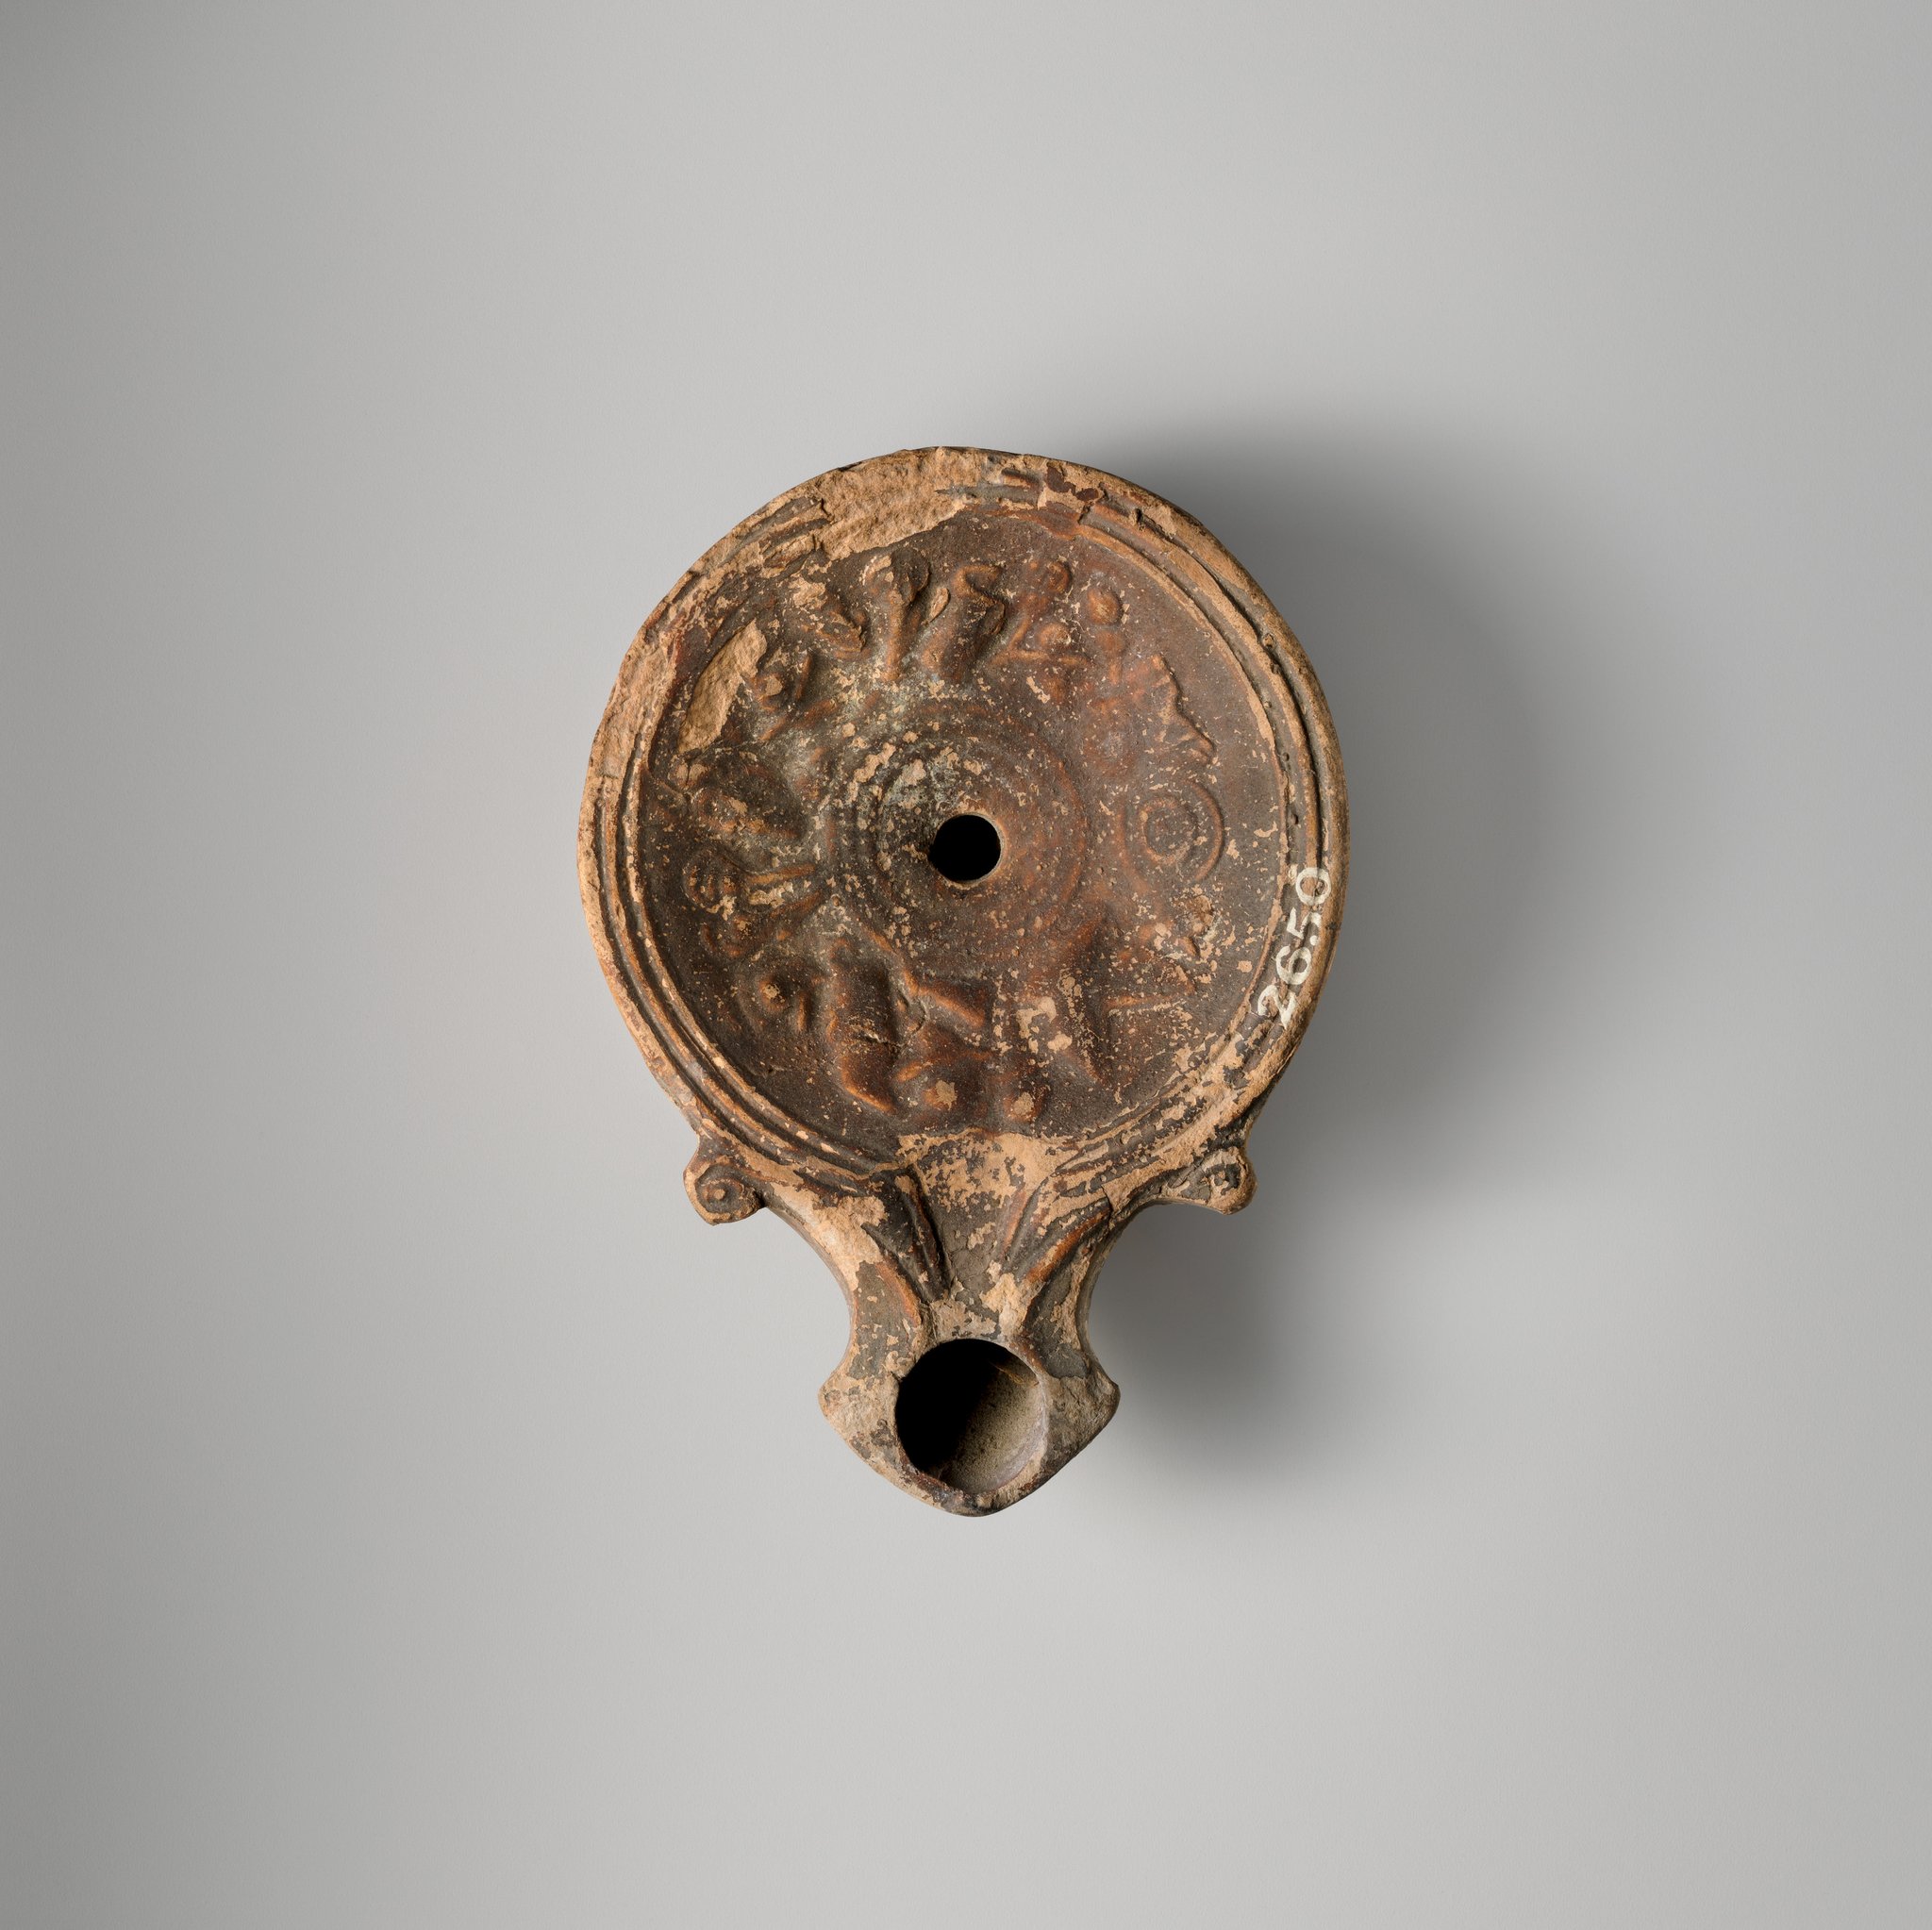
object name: lamp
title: Terracotta oil lamp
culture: roman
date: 20 BCE-25 CE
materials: terracotta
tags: weapons